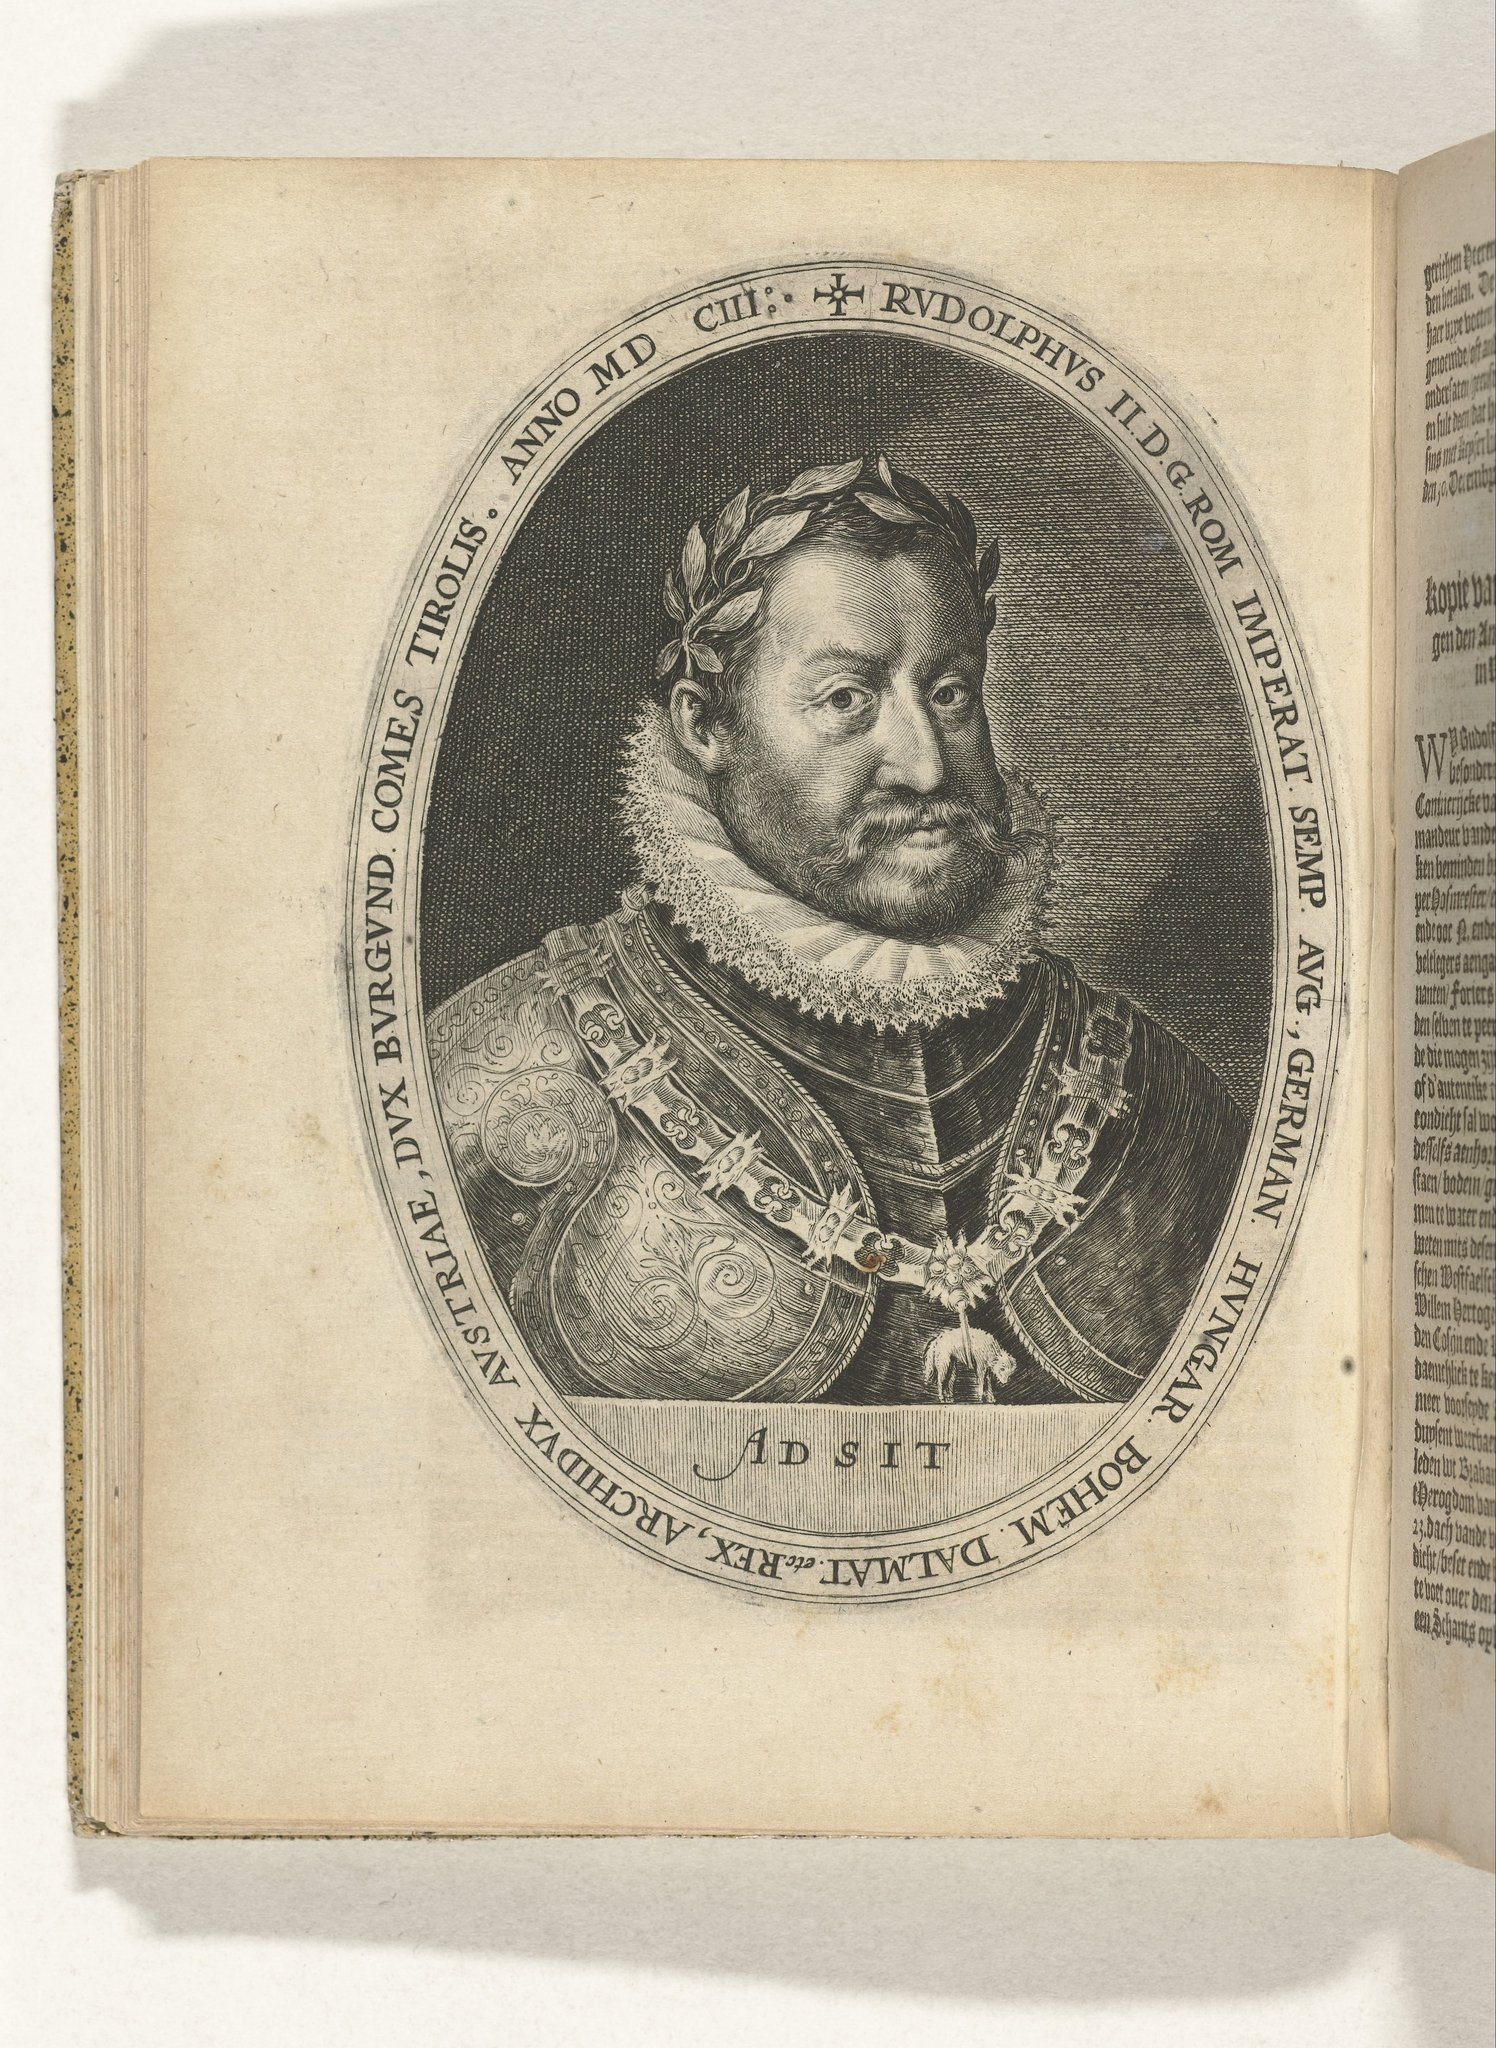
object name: pamphlet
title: Portret van keizer Rudolf II, 1603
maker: crispijn van de passe (i)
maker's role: draughtsman, print maker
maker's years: 1564-1637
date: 1599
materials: paper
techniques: engraving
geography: low countries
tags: vienna, prague, rudolf ii van habsburg (duits keizer)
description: Portret van de Habsburgse keizer Rudolf II, 1603. Ovaal portret met borstbeeld van de keizer, met randschrift in het Latijn. Opgenomen in het pamflet getiteld: Den Spaenschen ende Arragoenschen spiegel. Inde welcke men mach claerlick ende waerachtich sien tot wat eynde ... het voornemen is ... van 't Spaensche Crijchsvolck, dat hem desen Winter heeft gehouden in den Westphaelschen Creyts.